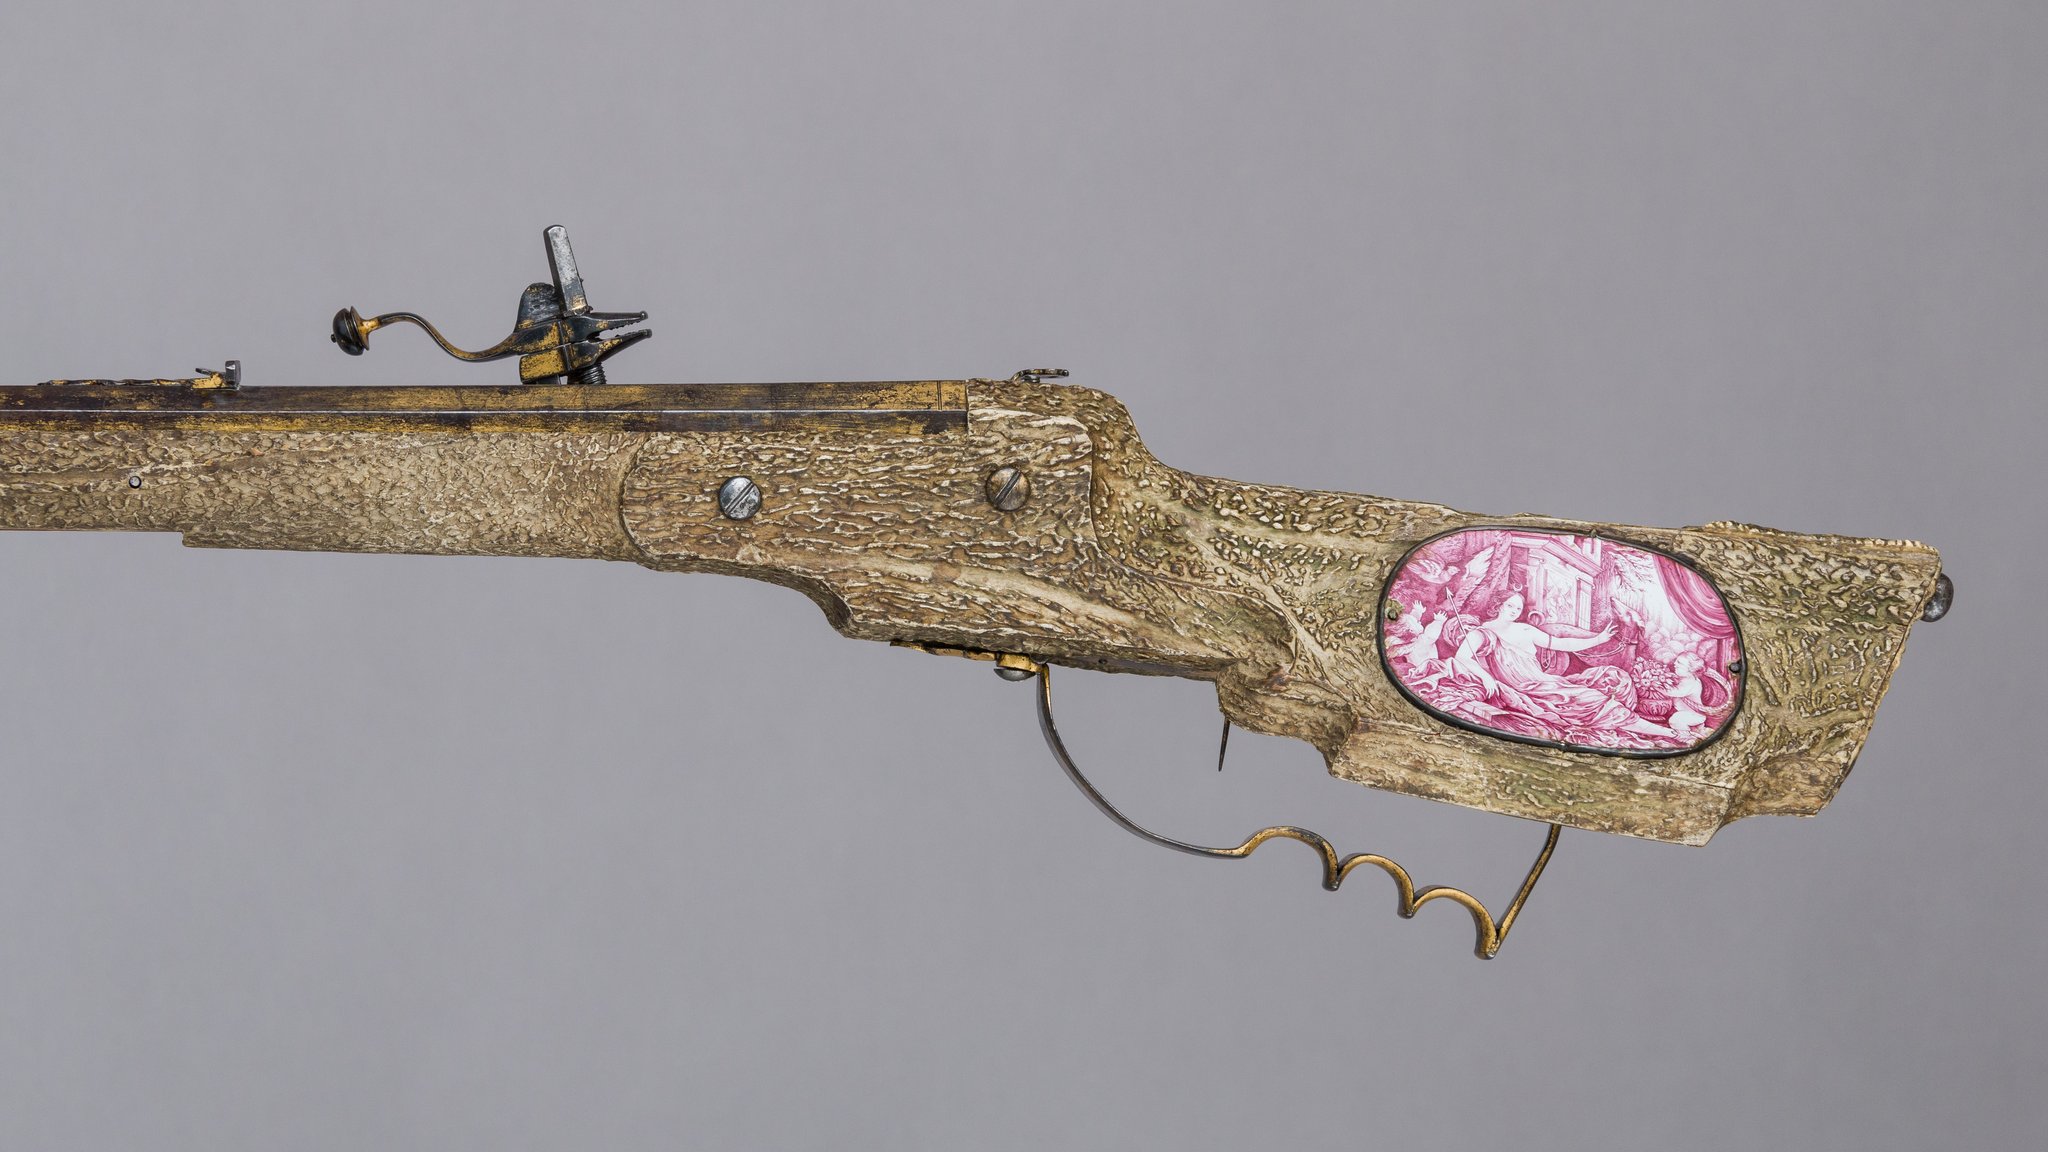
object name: wheellock rifle with spanner and accessory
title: Wheellock Rifle with Spanner, Shot Extracting Tool, and Shooting Patch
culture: german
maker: martin kammerer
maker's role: gunsmith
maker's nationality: german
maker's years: 1654-1667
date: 1665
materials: antler, bone, copper alloy, enamel, gold, iron, steel, textile, wood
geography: germany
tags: women,putti